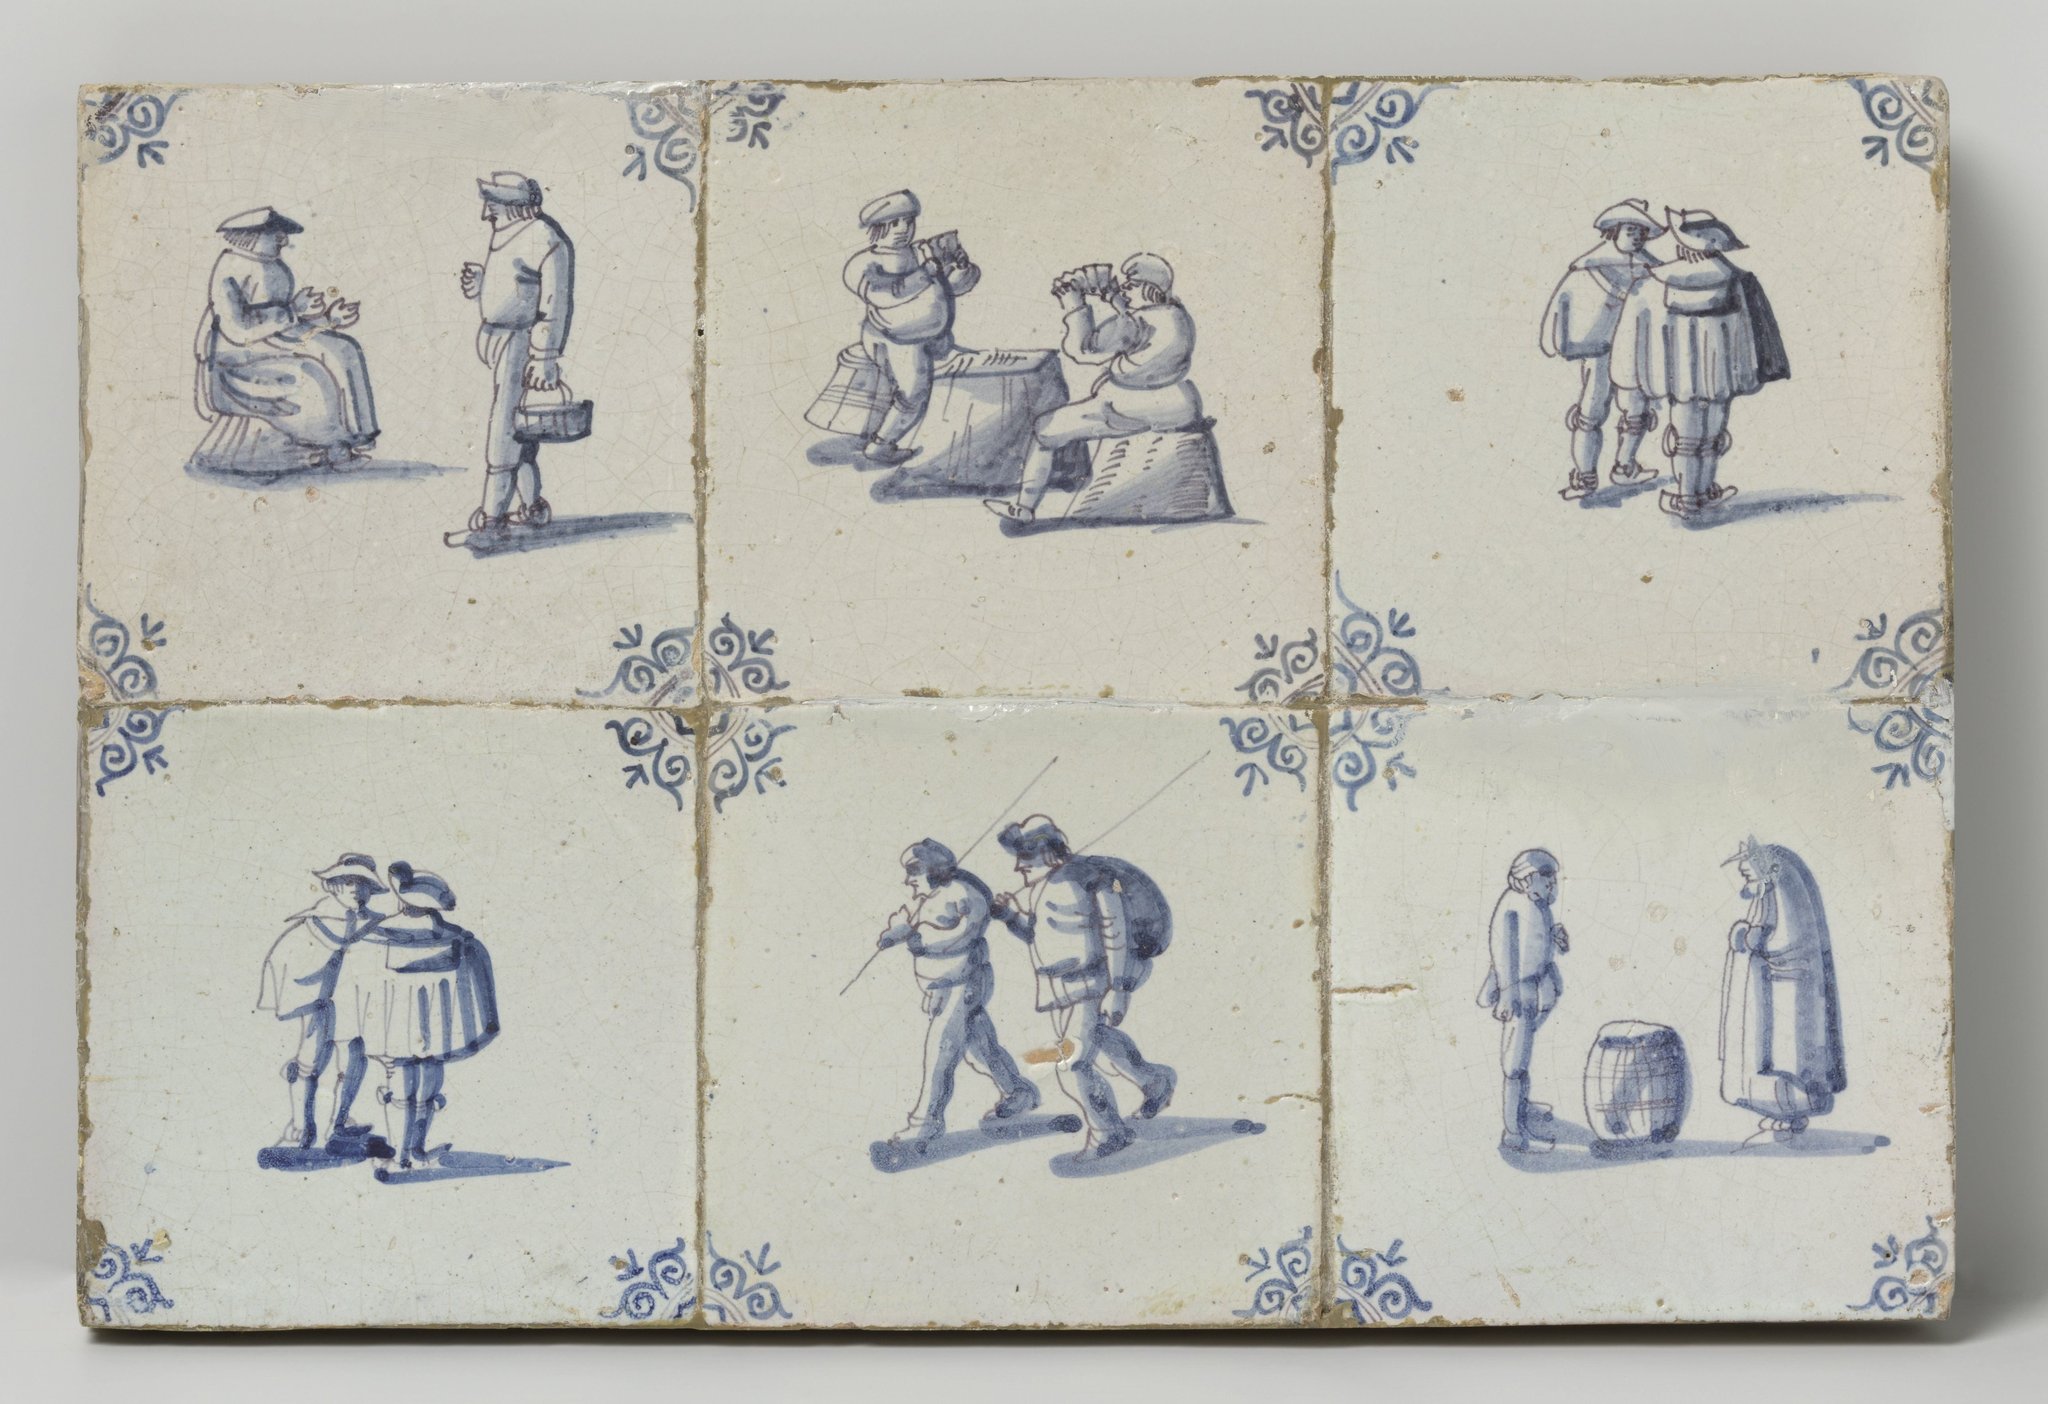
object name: tegelveld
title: Veld van zes tegels met mensen en hun bezigheden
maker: Anonymous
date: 1625-1650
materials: earthenware, glaze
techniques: maiolica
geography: netherlands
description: Veld van zes tegels (2 x 3) elk met een blauw en paars geschilderde voorstelling van twee figuren en hun bezigheden. In de hoeken, een ossenkop.